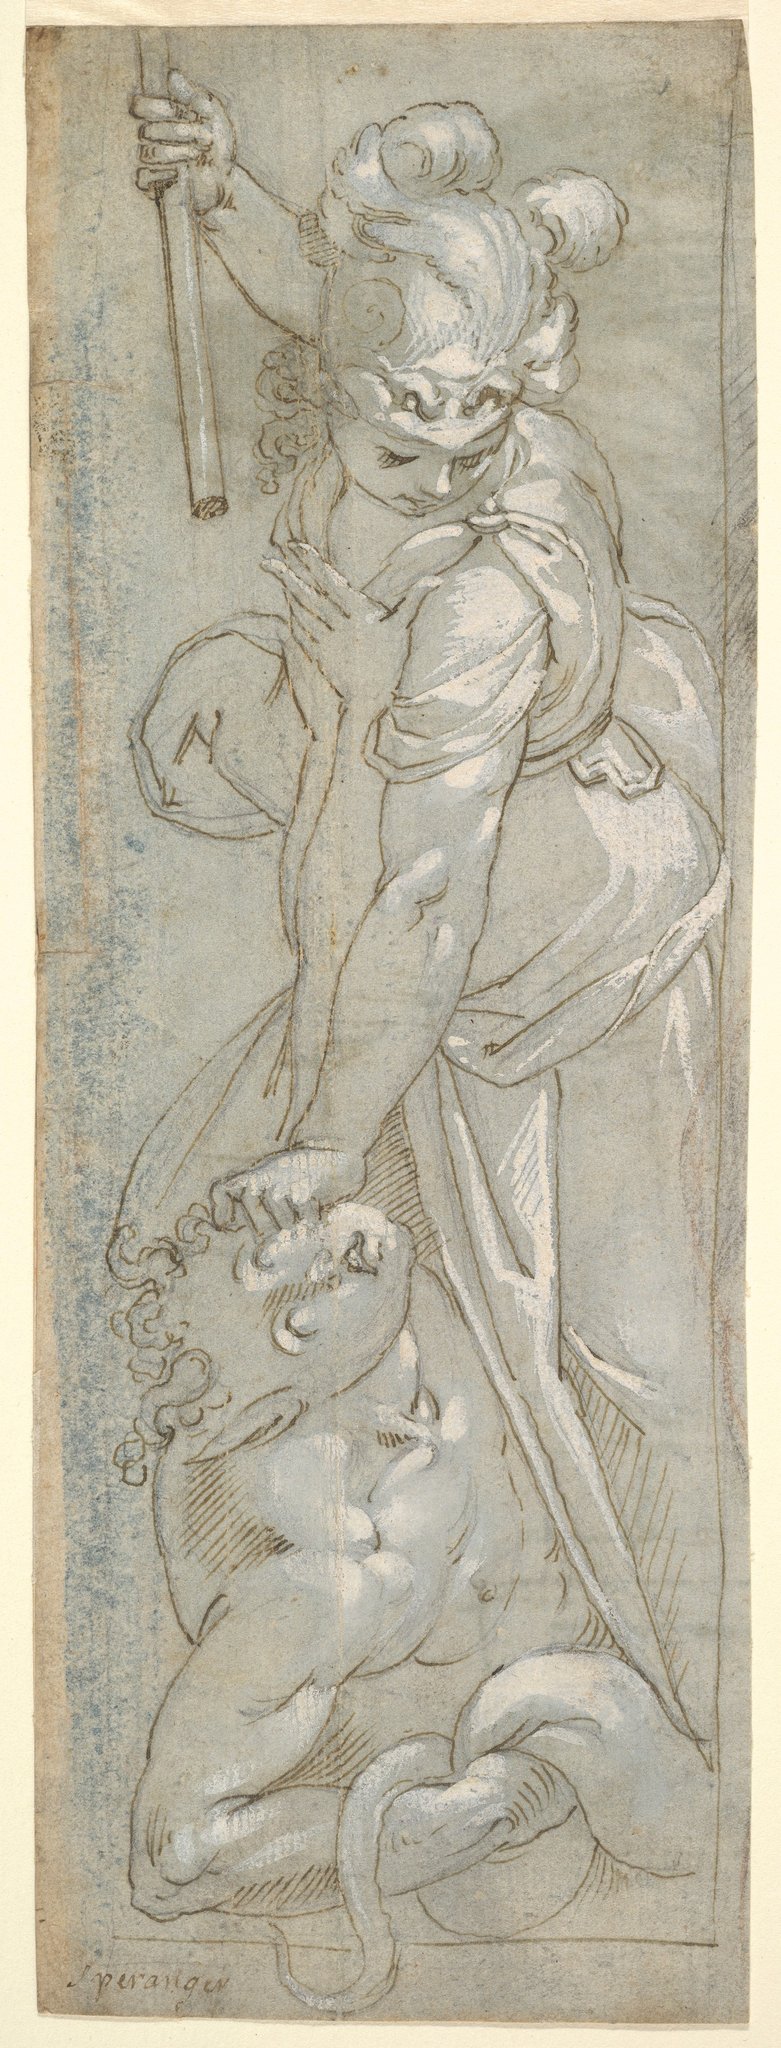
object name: drawing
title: Female Warrior crushing a Satyr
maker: anonymous, 16th century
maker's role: artist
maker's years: 1500-1600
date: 1501-1600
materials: chalk, ink, paper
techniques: heightening, pen, wash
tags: women,satyrs